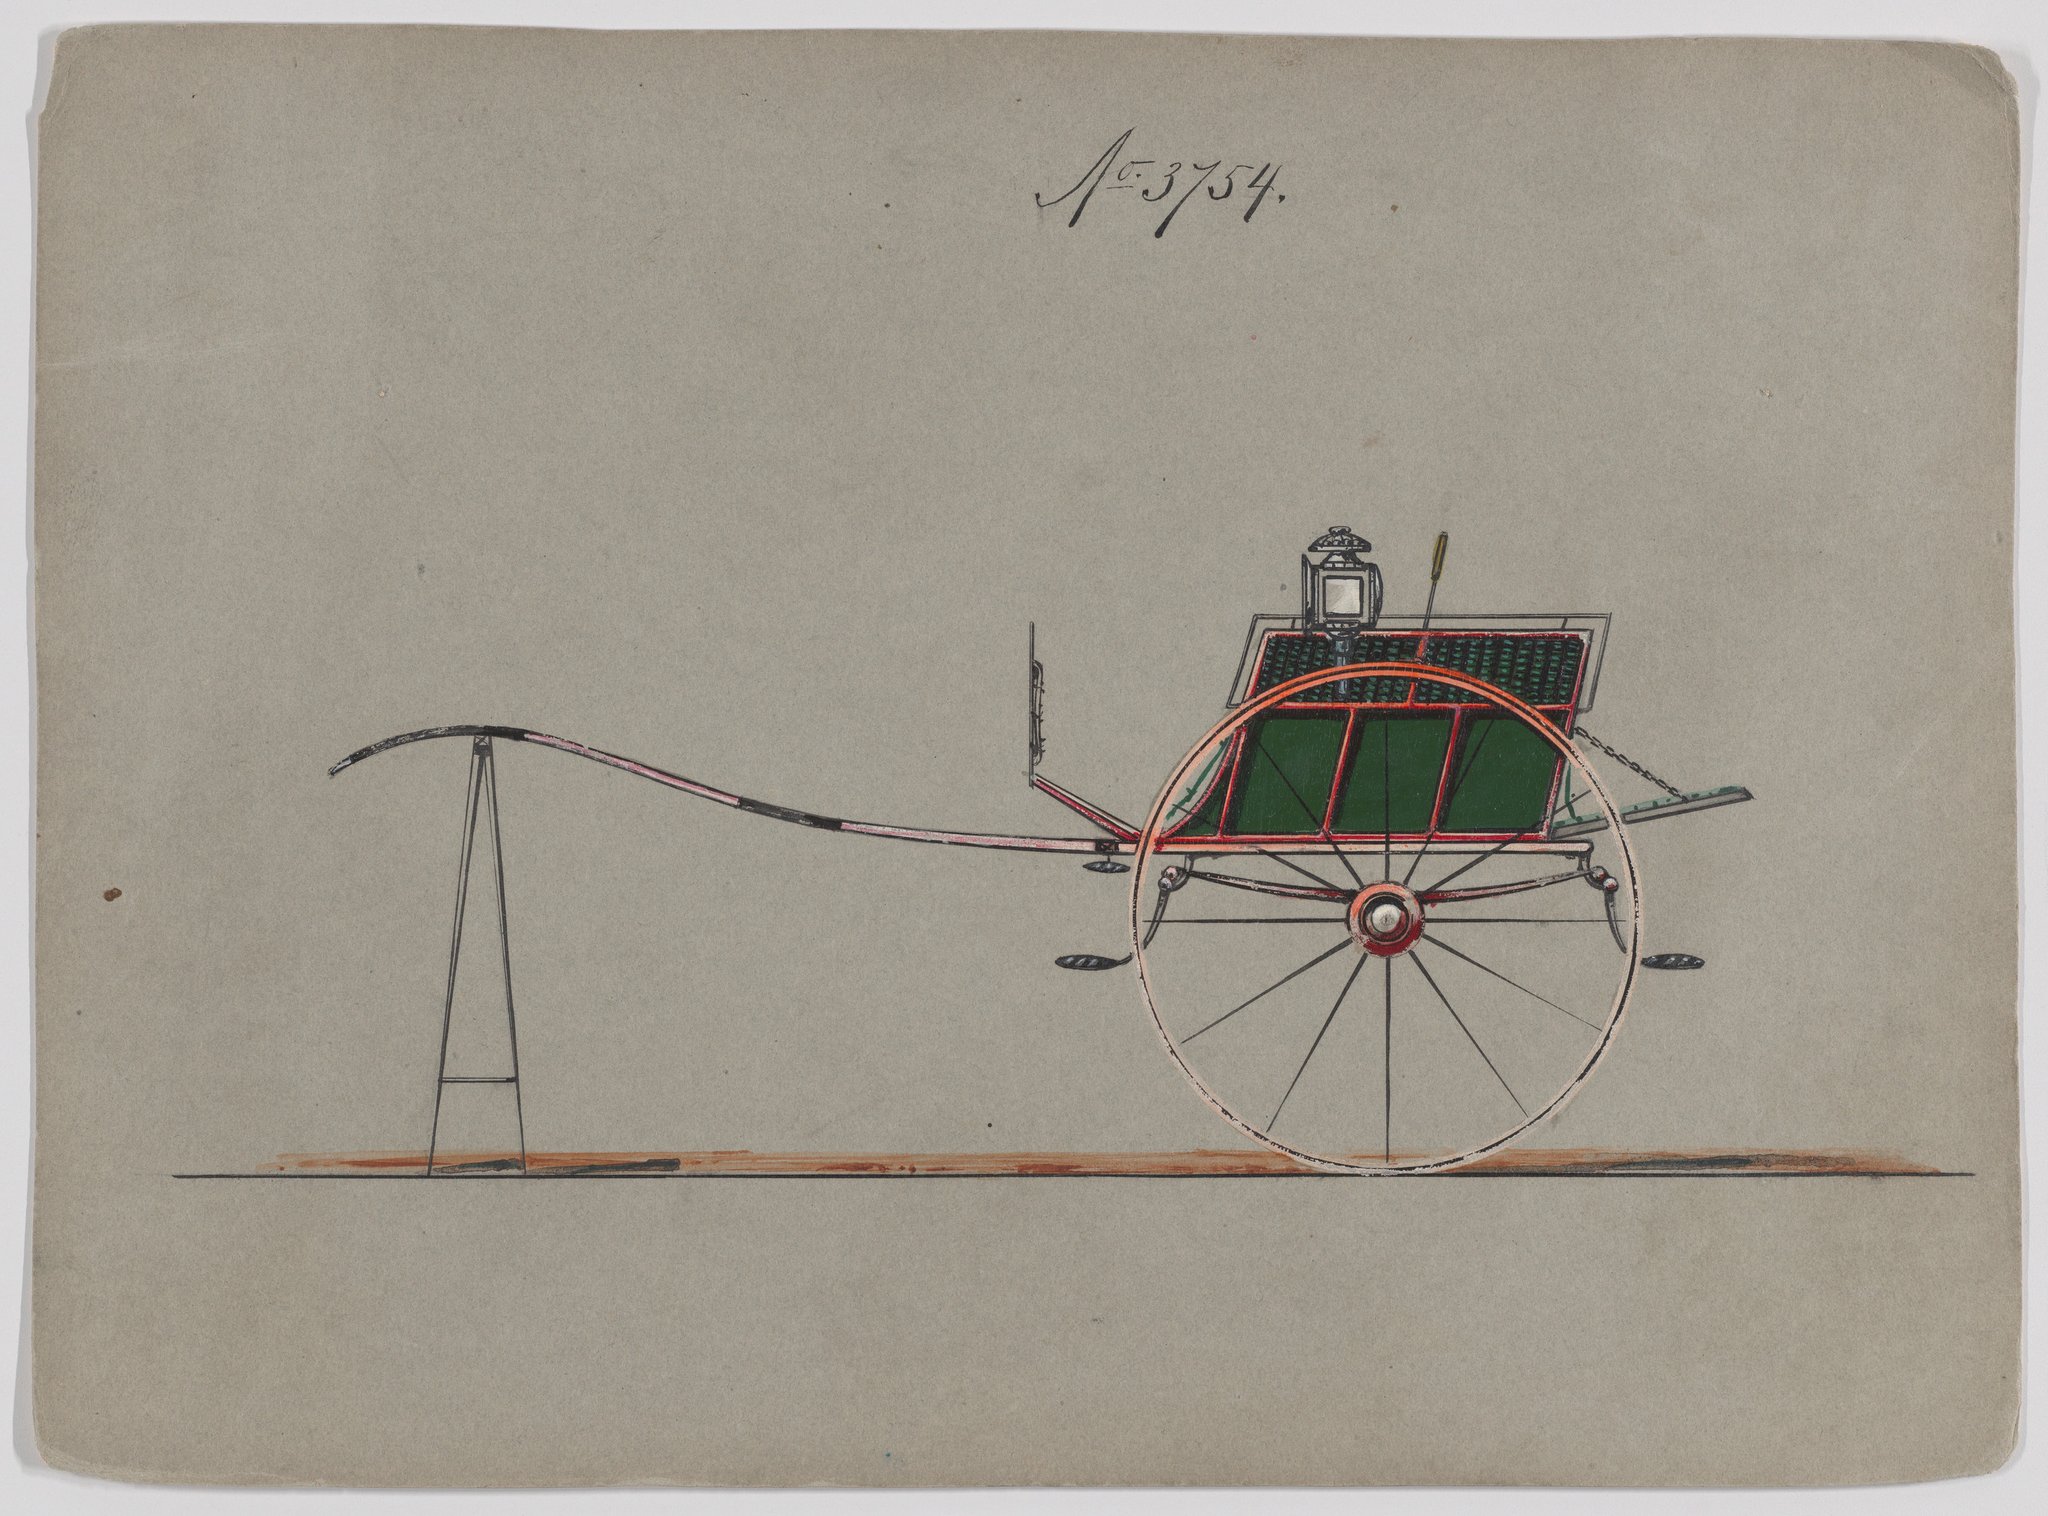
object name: drawing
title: Dog Cart # 3754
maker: brewster & co.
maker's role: manufacturer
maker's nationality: american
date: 1882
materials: gouache, gum arabic, ink, watercolor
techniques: pen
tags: carriages